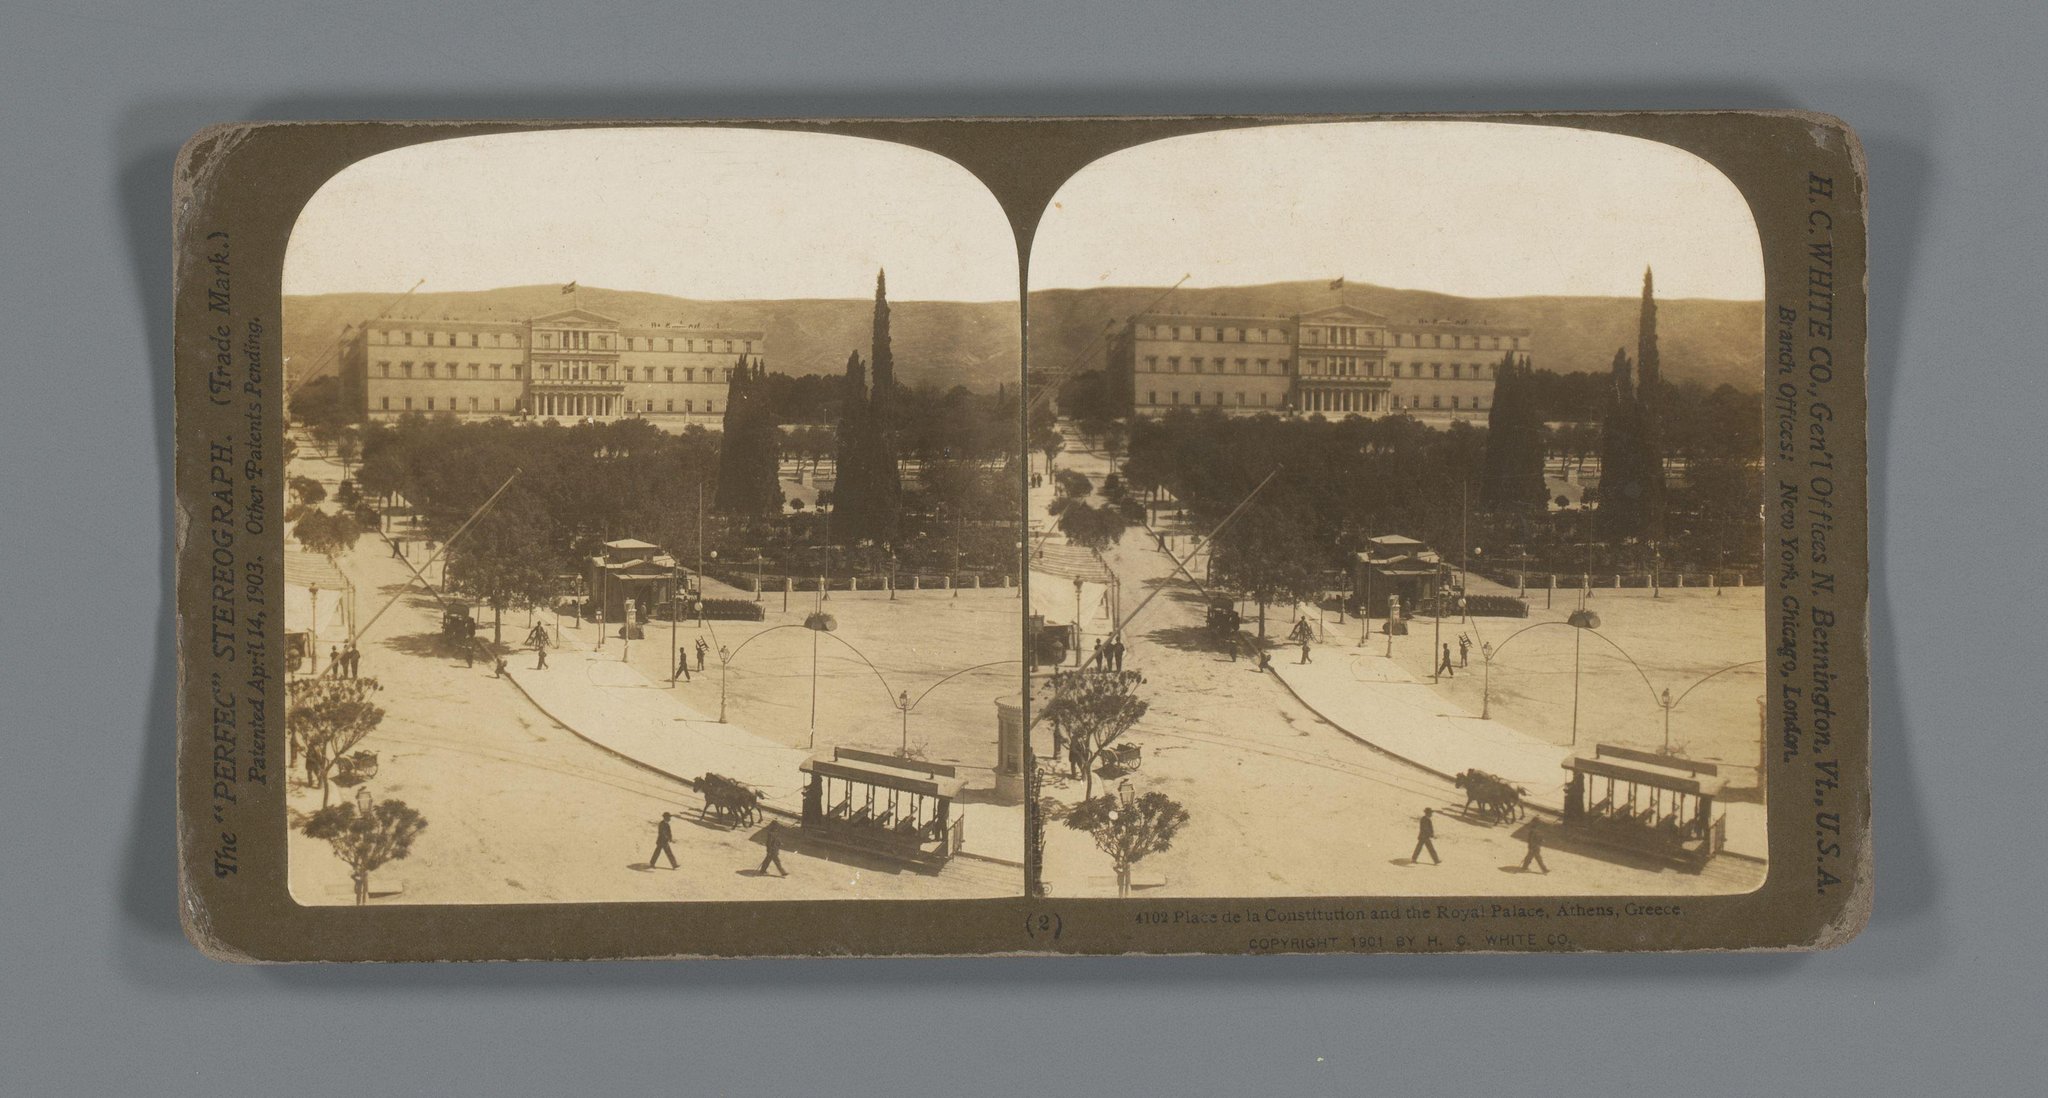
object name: stereograph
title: Gezicht op het Syntagmaplein en het Koninklijk Paleis in Athene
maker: Anonymous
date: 1901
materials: cardboard, photographic support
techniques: gelatin silver print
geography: athens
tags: square, place, circus, etc., palace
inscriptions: inscription: ‘The " PERFEC" STEREOGRAPH. (Trade Mark.)/ Patented April 14, 1903. Other Patents Pending.’, number: ‘(2)’, copyright notice: ‘Copyright 1901 by H. C. White Co.’, number: ‘4102’, inscription: ‘W’